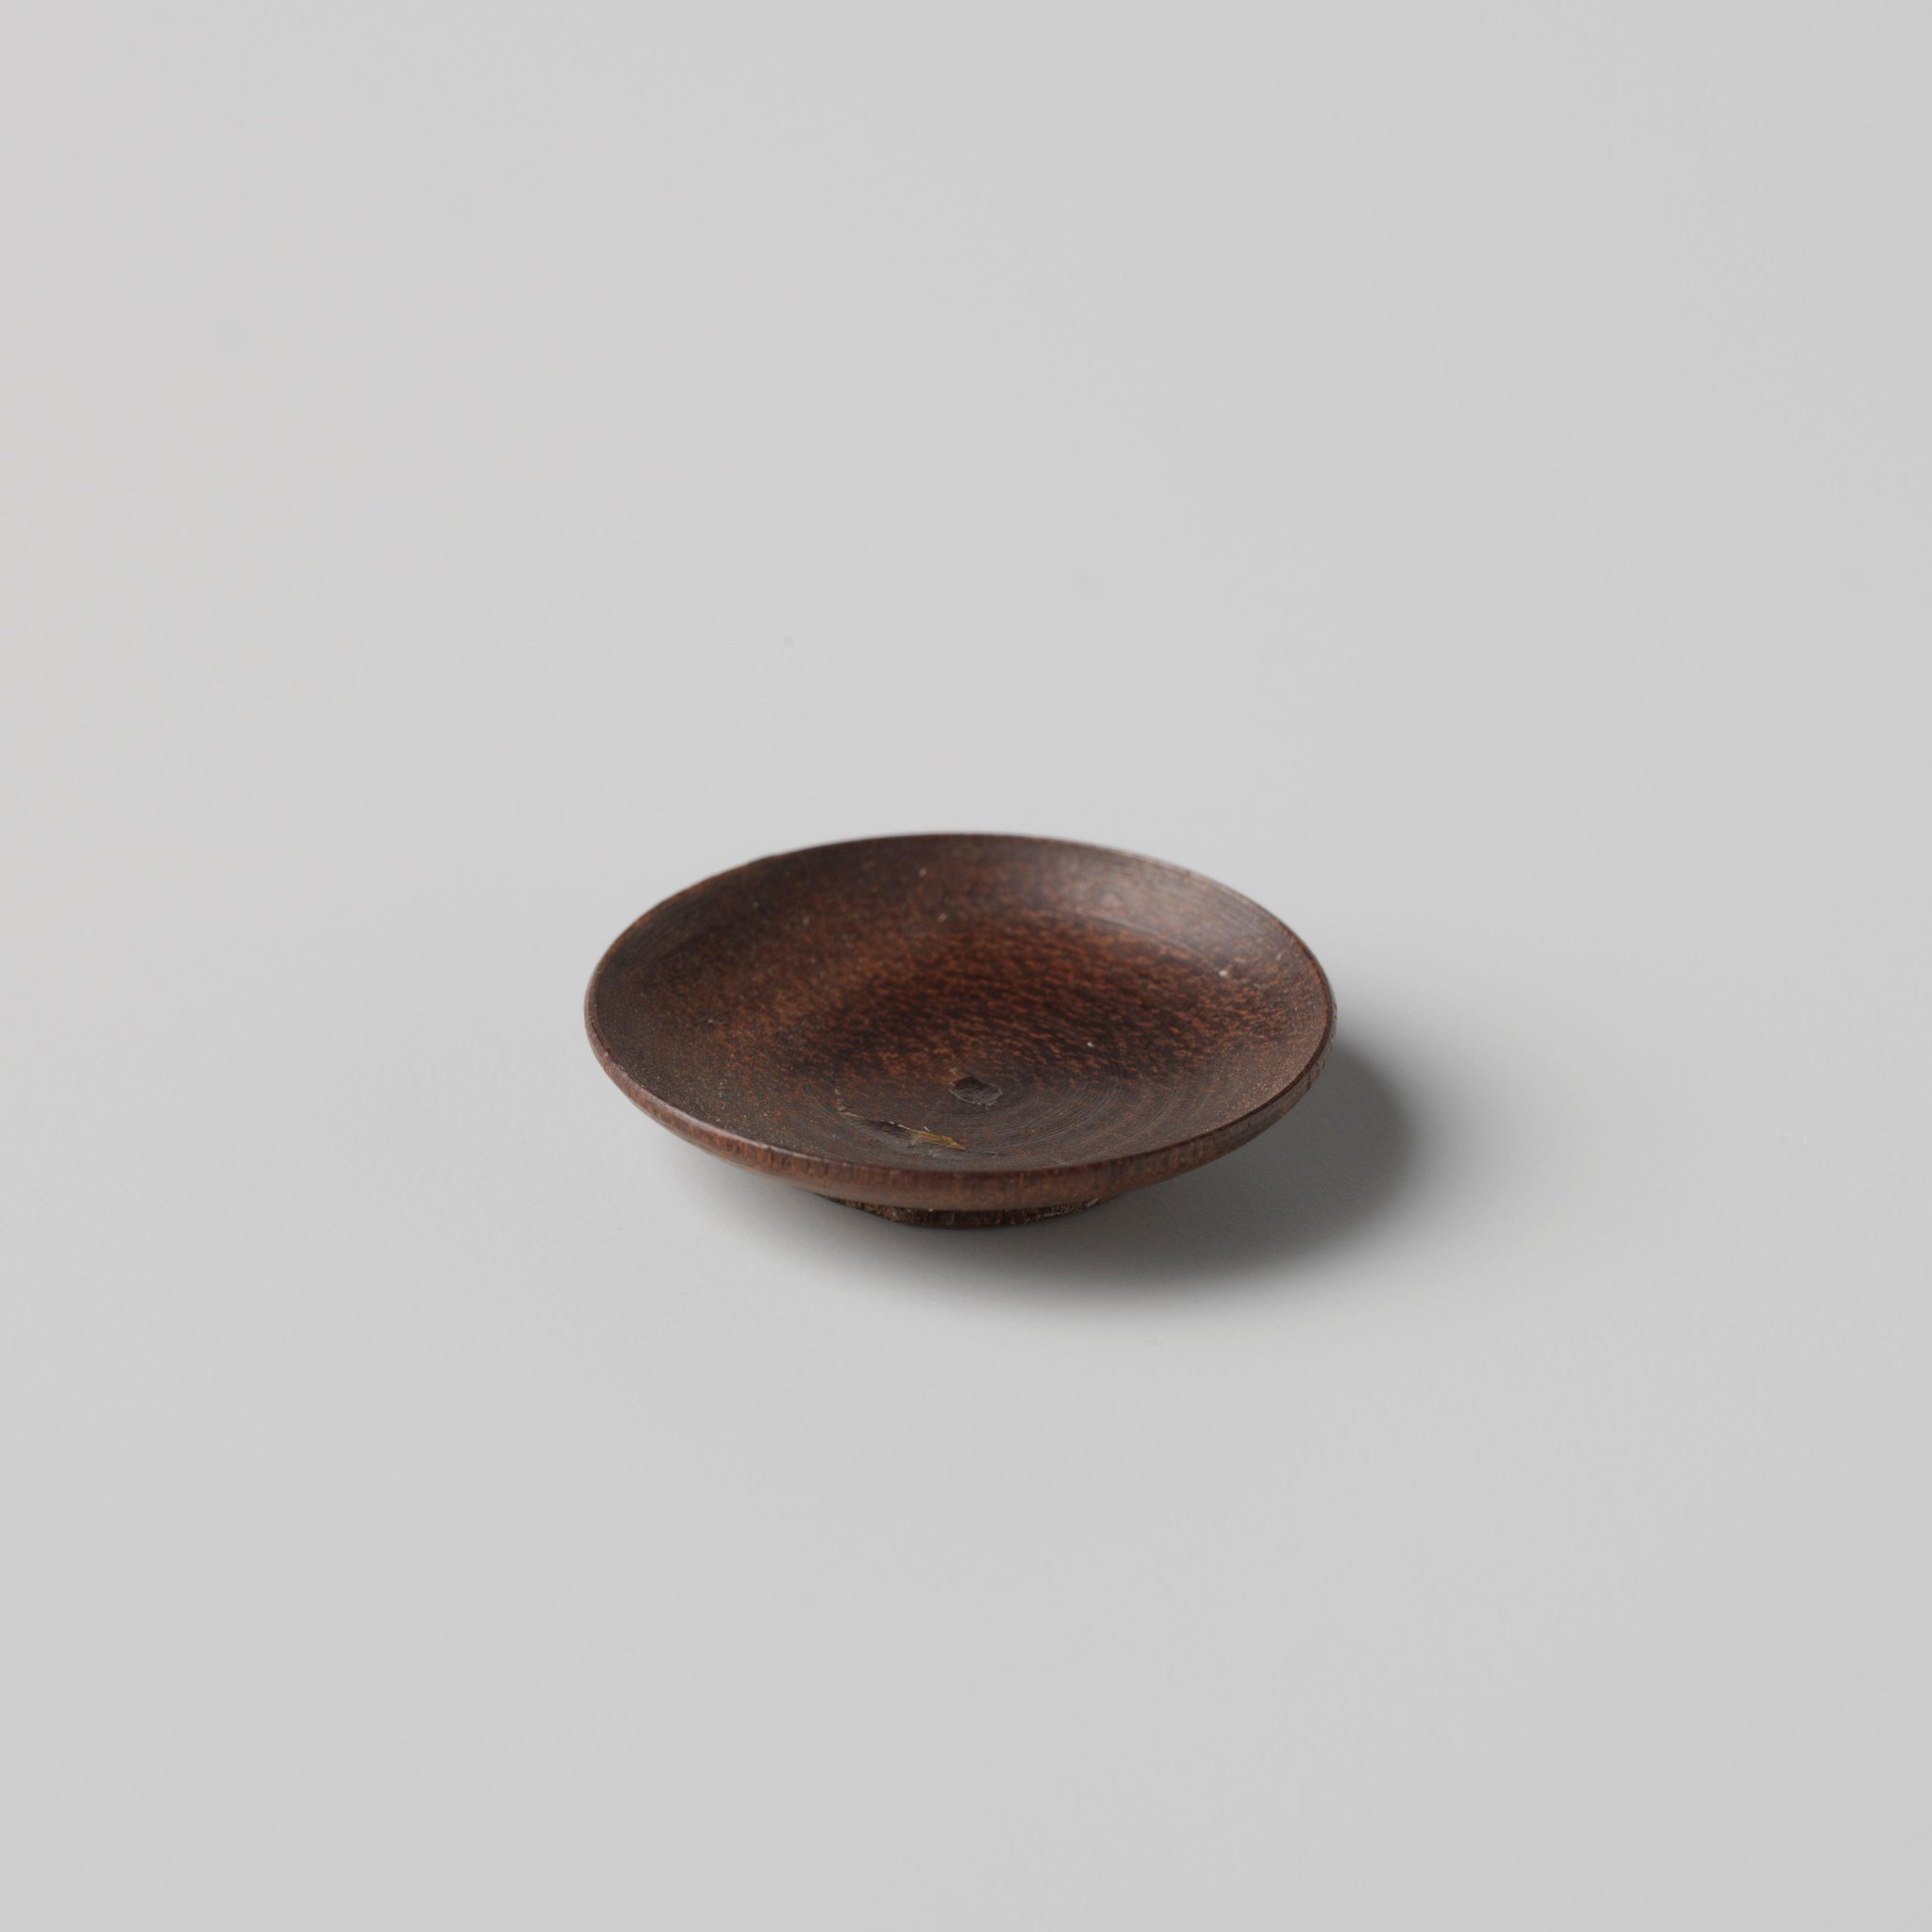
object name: miniature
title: Schotel van gedraaid hout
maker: Anonymous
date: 1800-1899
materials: wood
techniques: tropisch hardhout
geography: england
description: Schotel zonder rand, gedraaid van een donkere hardhoutsoort.